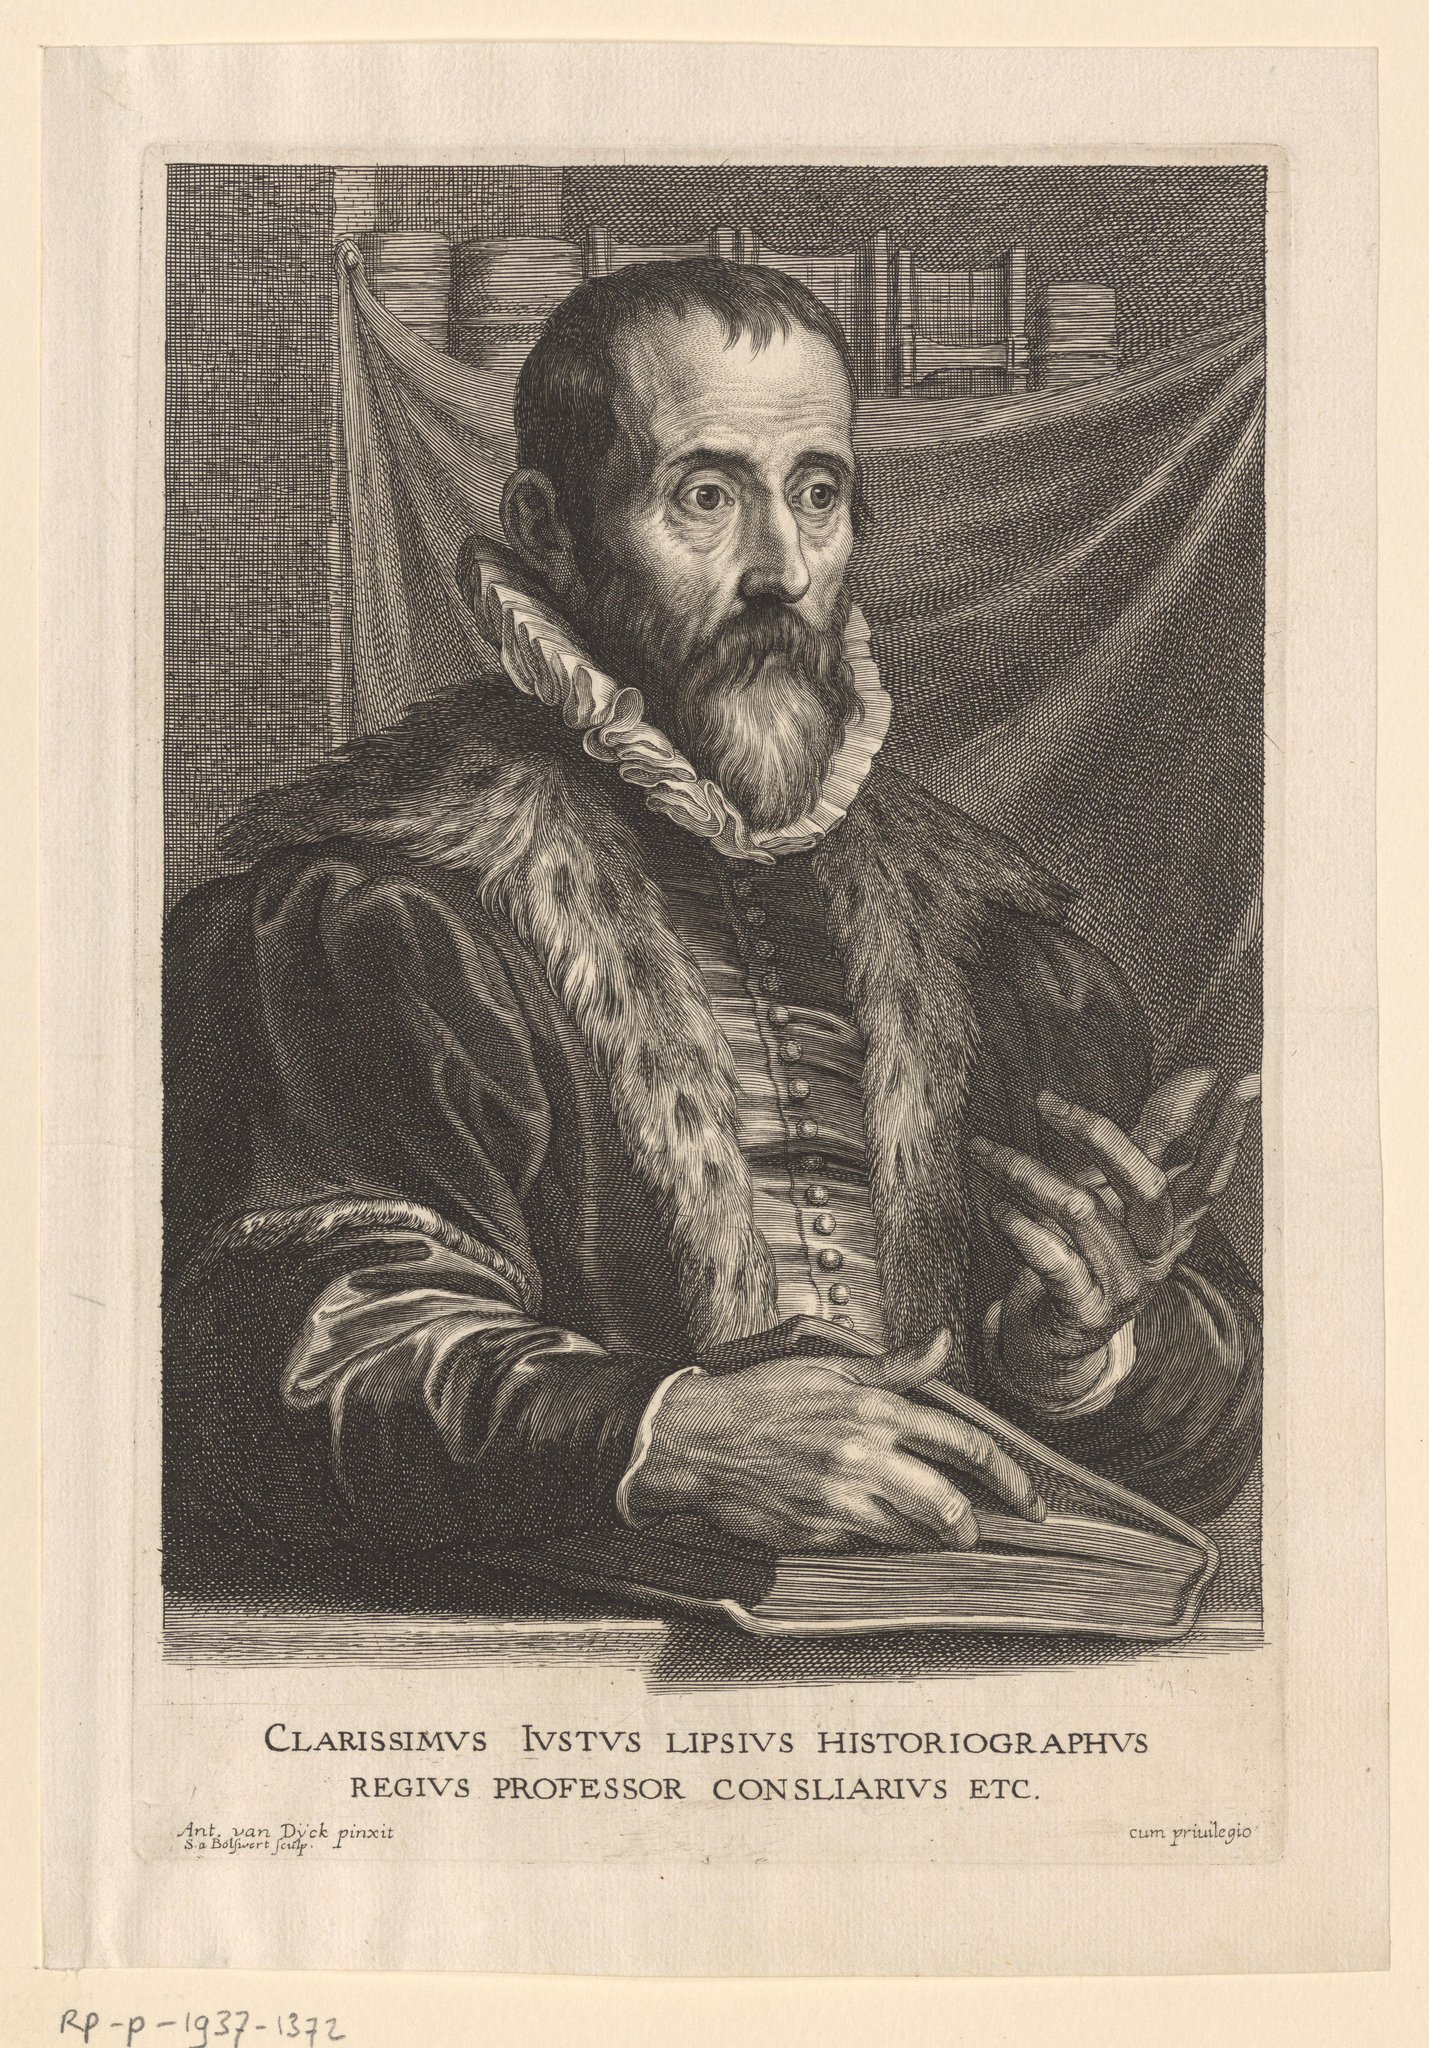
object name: print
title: Iconographie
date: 1640-1645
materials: paper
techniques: engraving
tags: louvain, justus lipsius, history and archaeology (+ portrait of scholar, scientist), historical persons, book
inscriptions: collector's mark: Lugt 2228